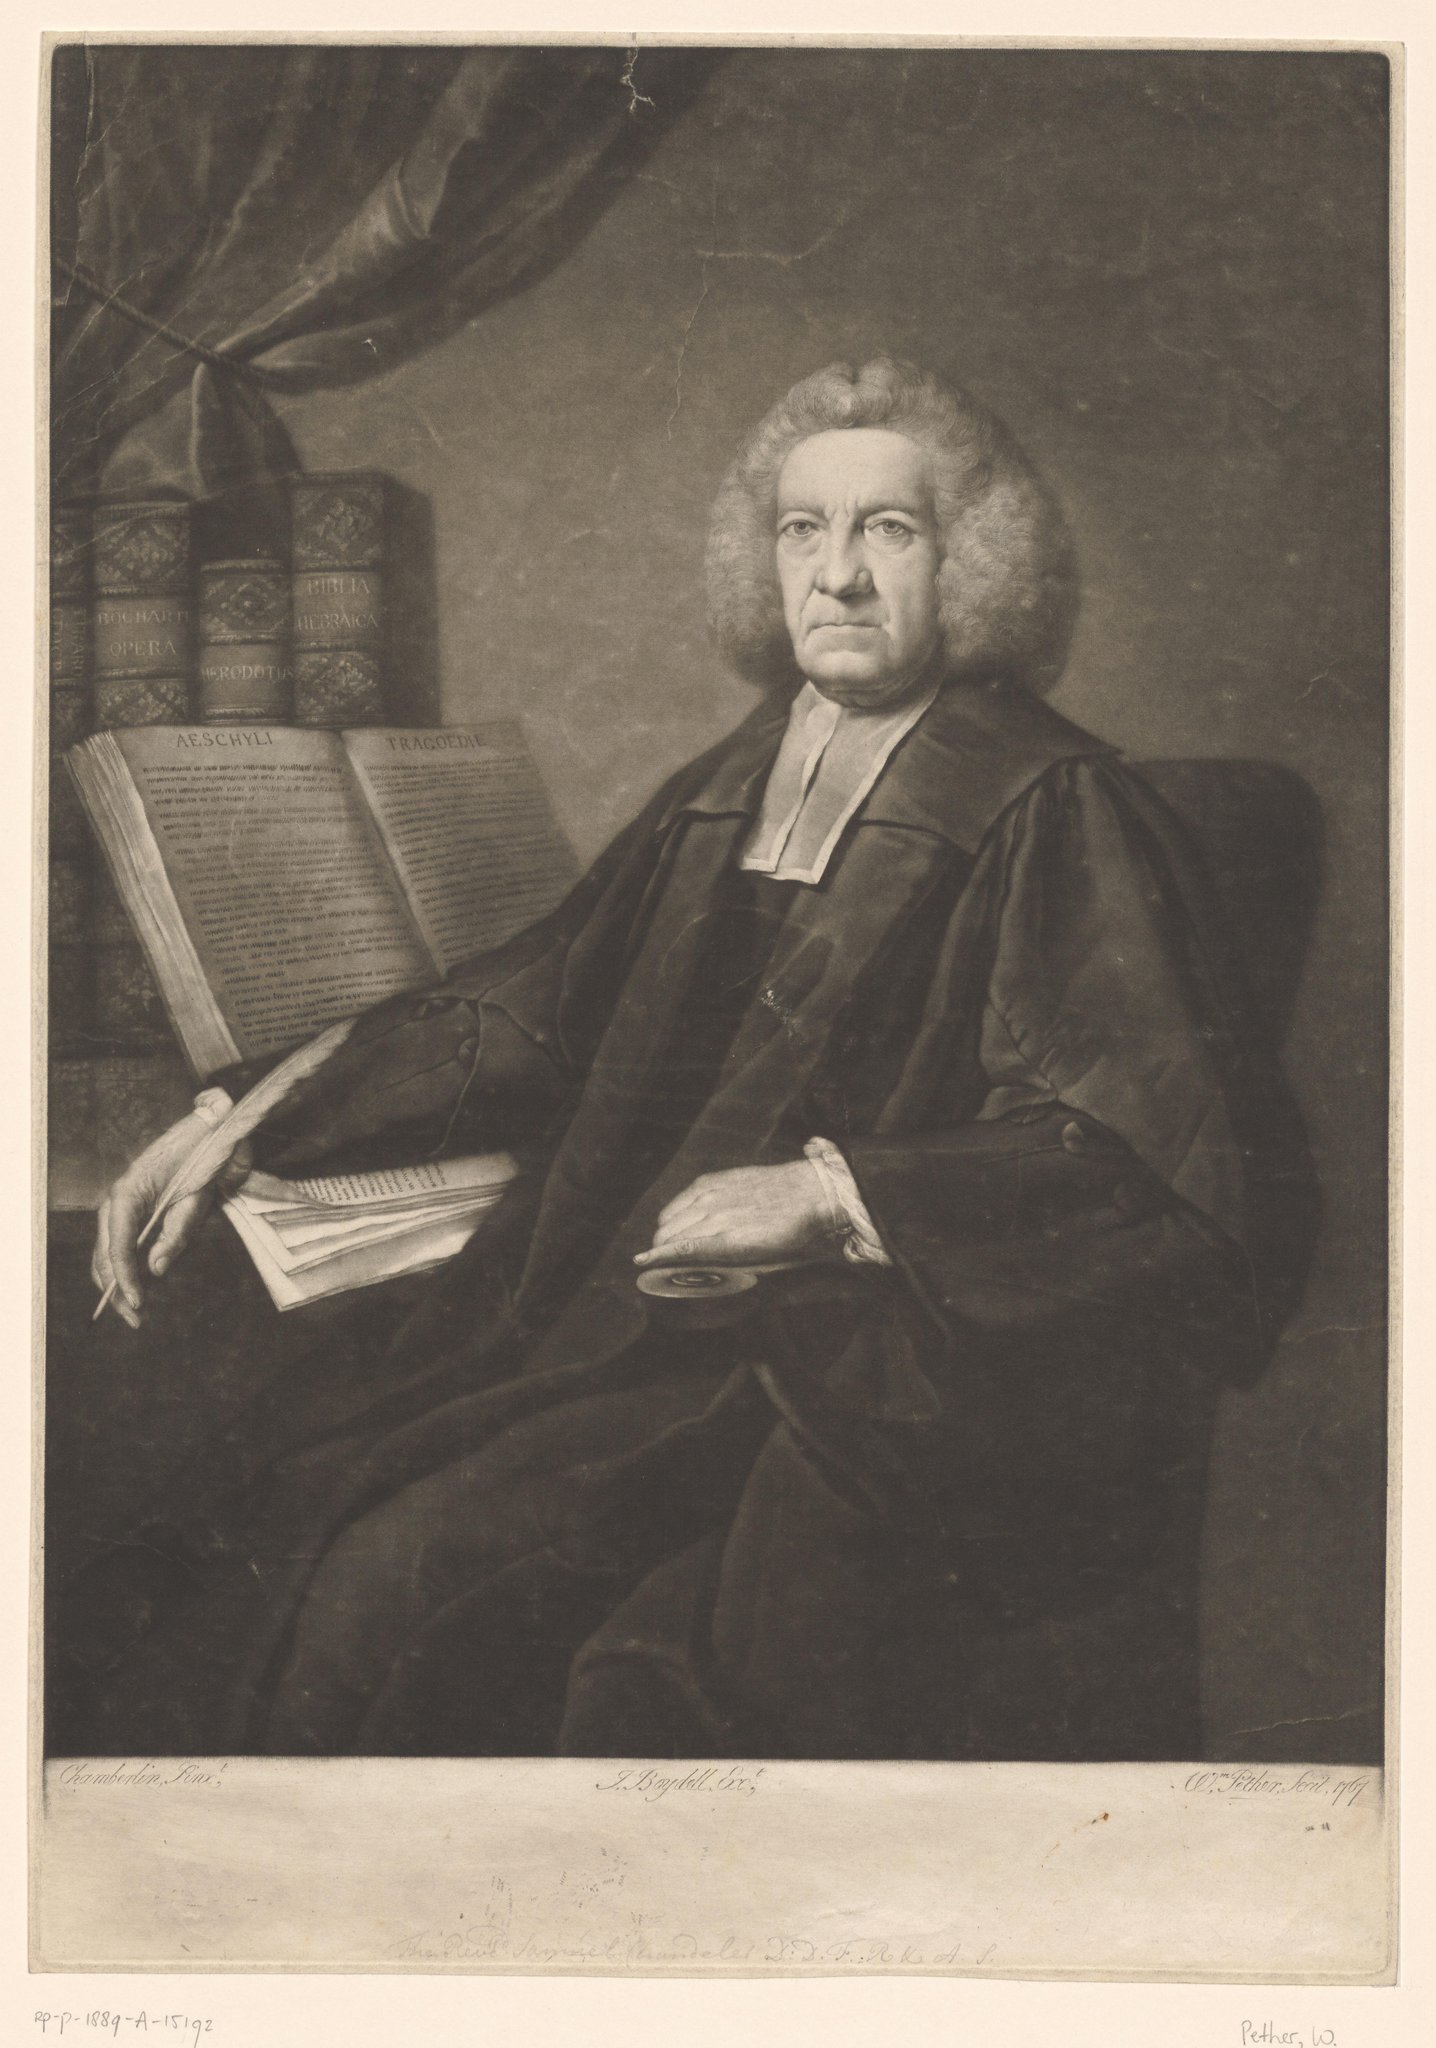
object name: print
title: Portret van Samuel Chandler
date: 1767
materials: paper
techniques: etching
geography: london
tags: london, historical persons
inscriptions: collector's mark: Lugt 2228